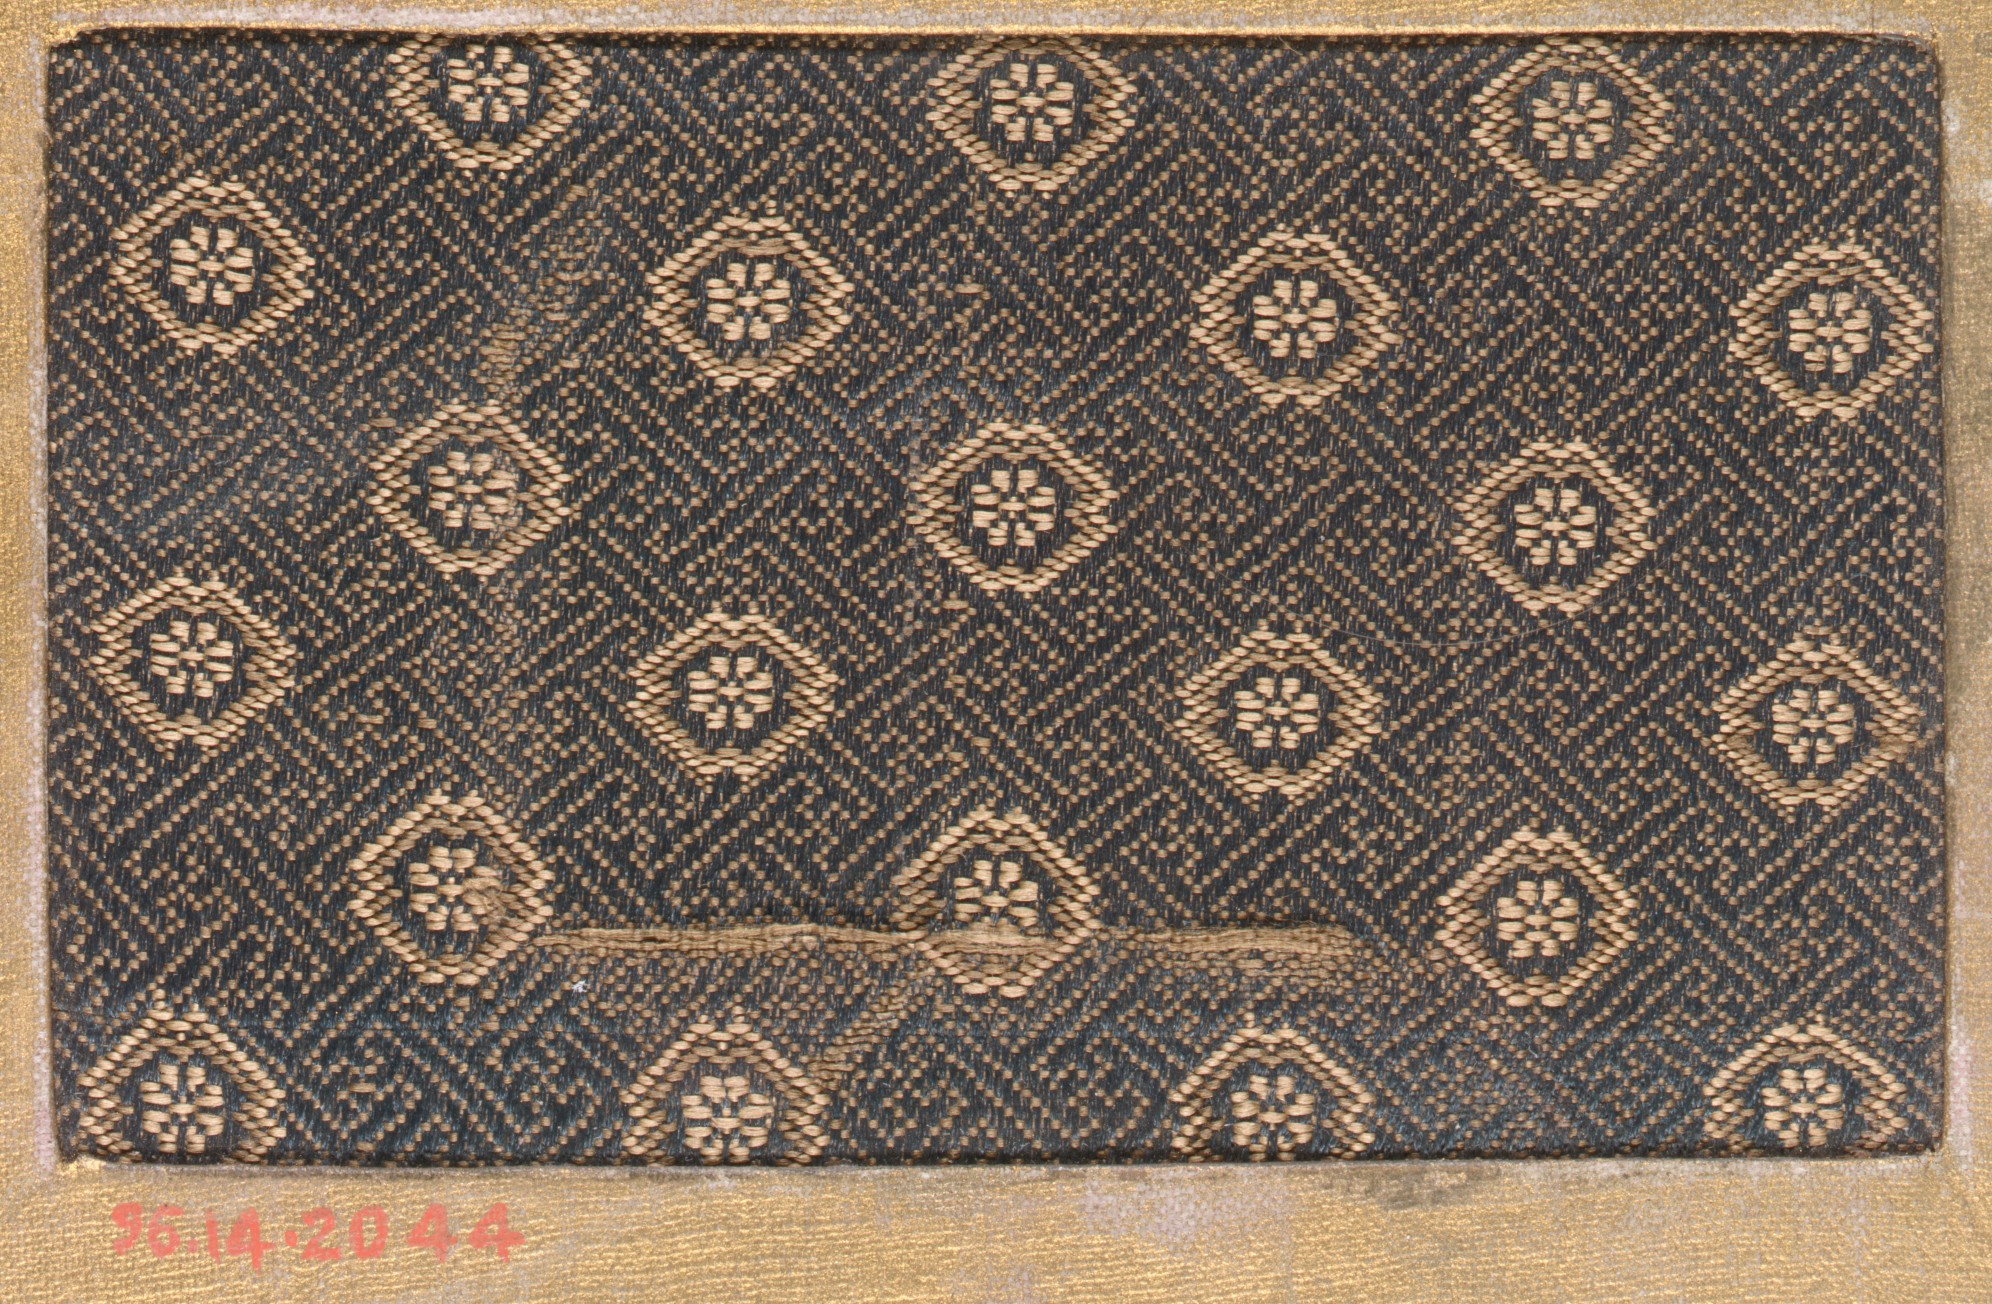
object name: piece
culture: japanese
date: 1701-1900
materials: silk